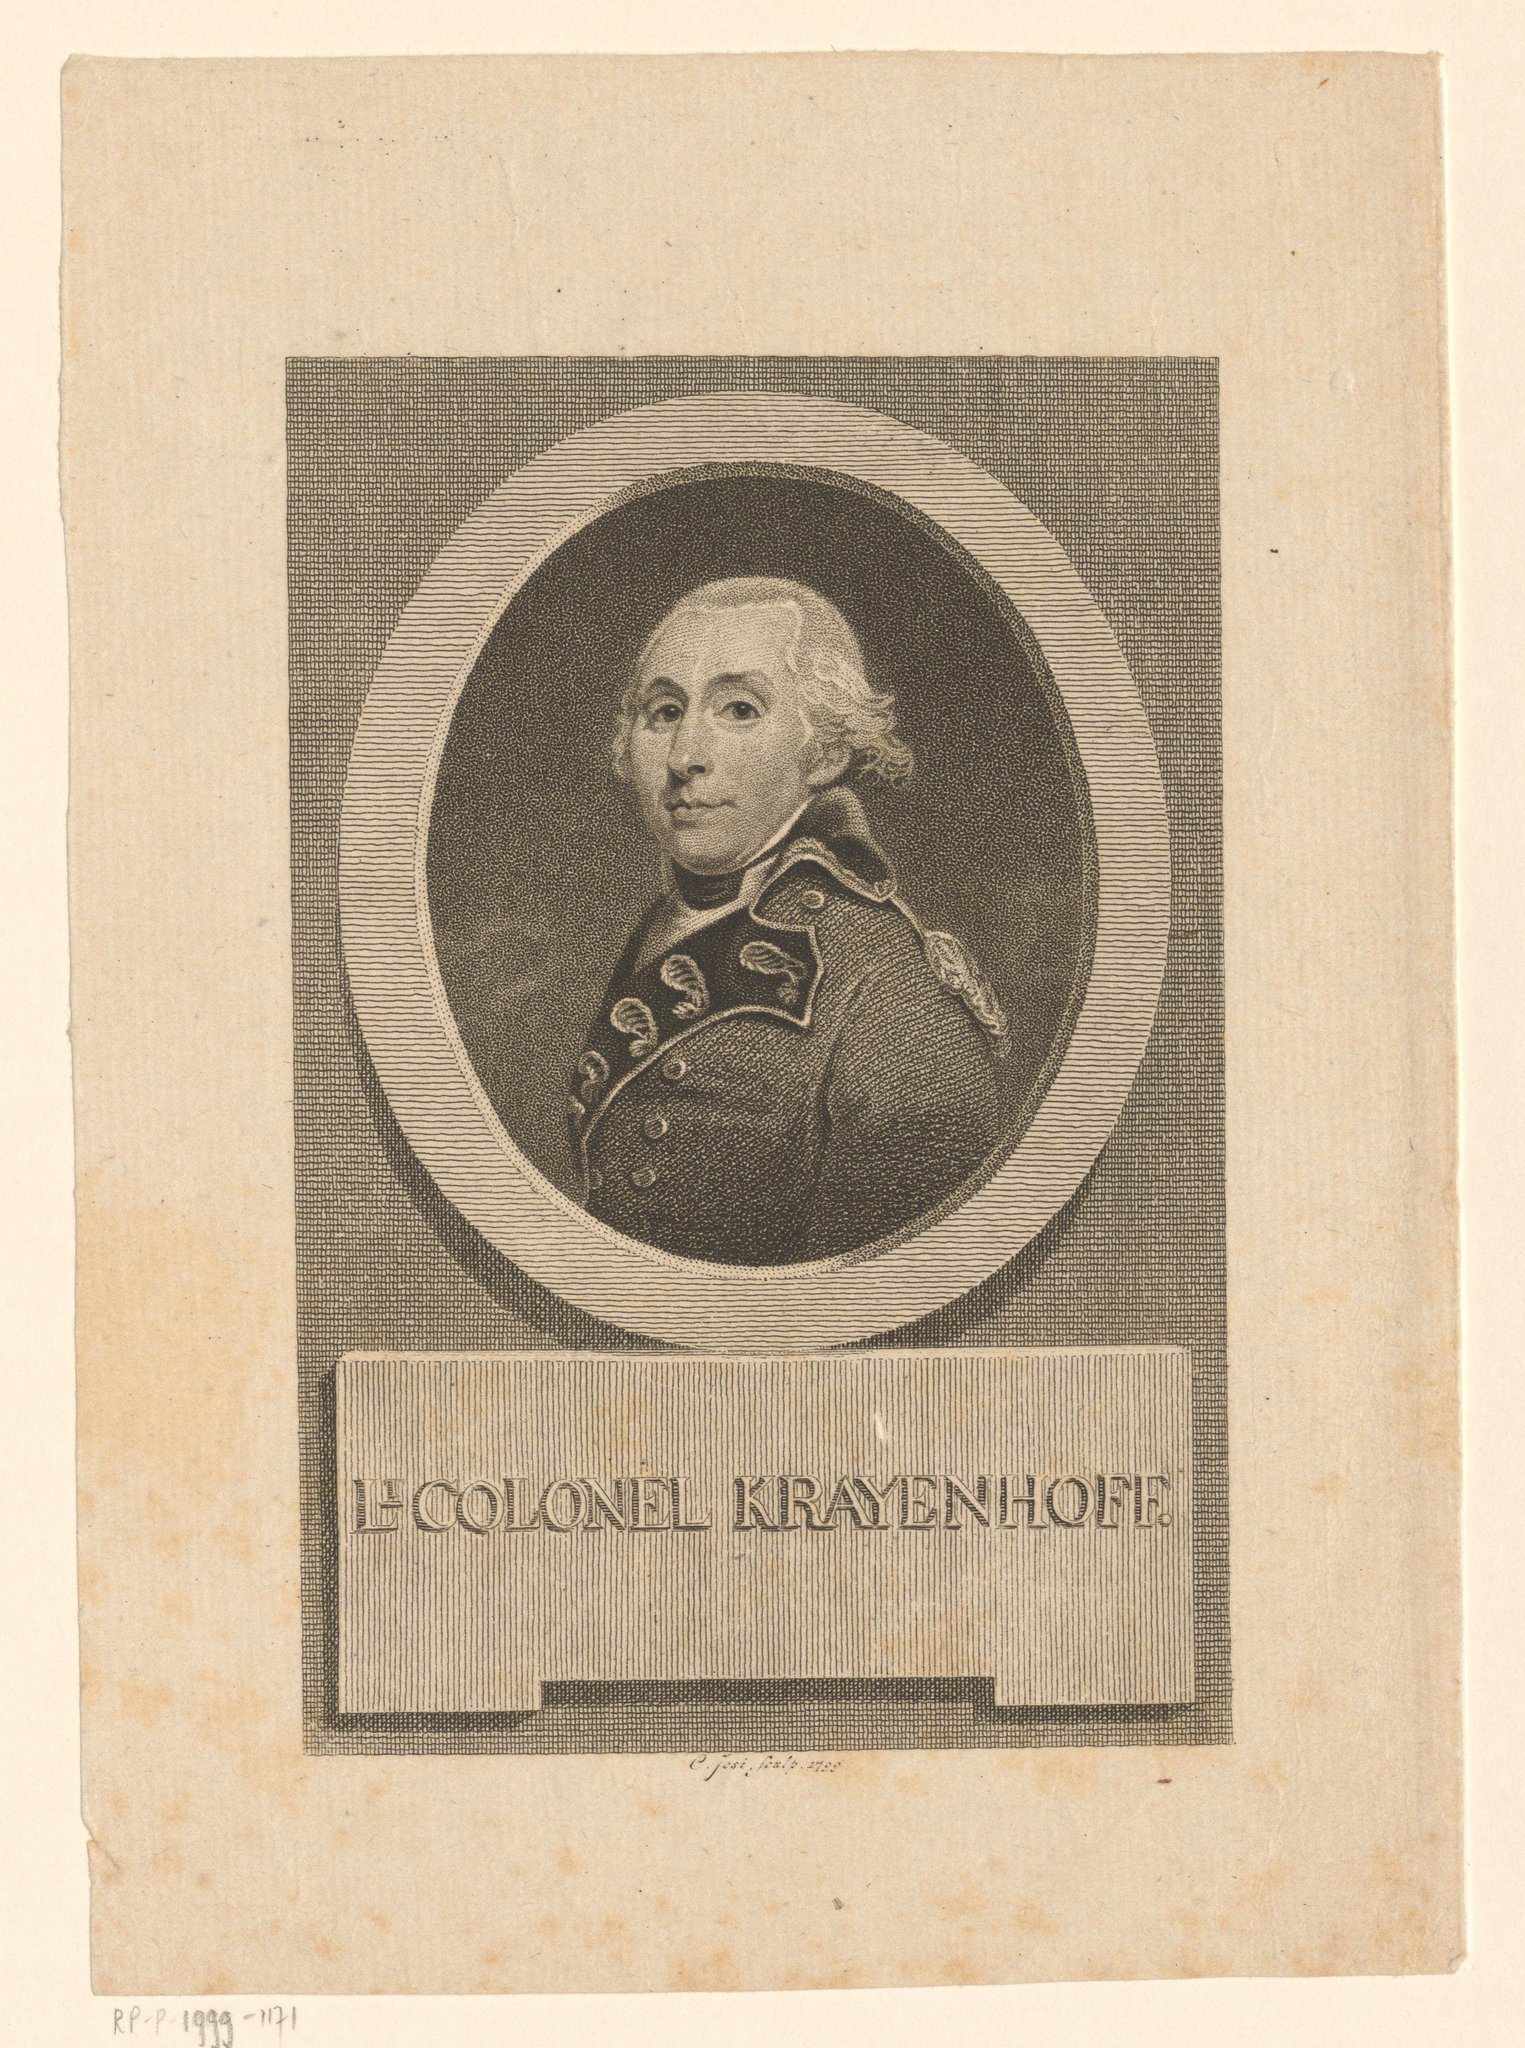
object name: print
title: Portret van Cornelis Rudolphus Theodorus Krayenhoff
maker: christiaan josi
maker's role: draughtsman, print maker, publisher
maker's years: 1765-1828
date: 1799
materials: paper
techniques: engraving, etching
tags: nijmegen, physicist, cornelis rudolphus theodorus krayenhoff, historical persons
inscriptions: collector's mark: Lugt 2760, collector's mark: Lugt 2228